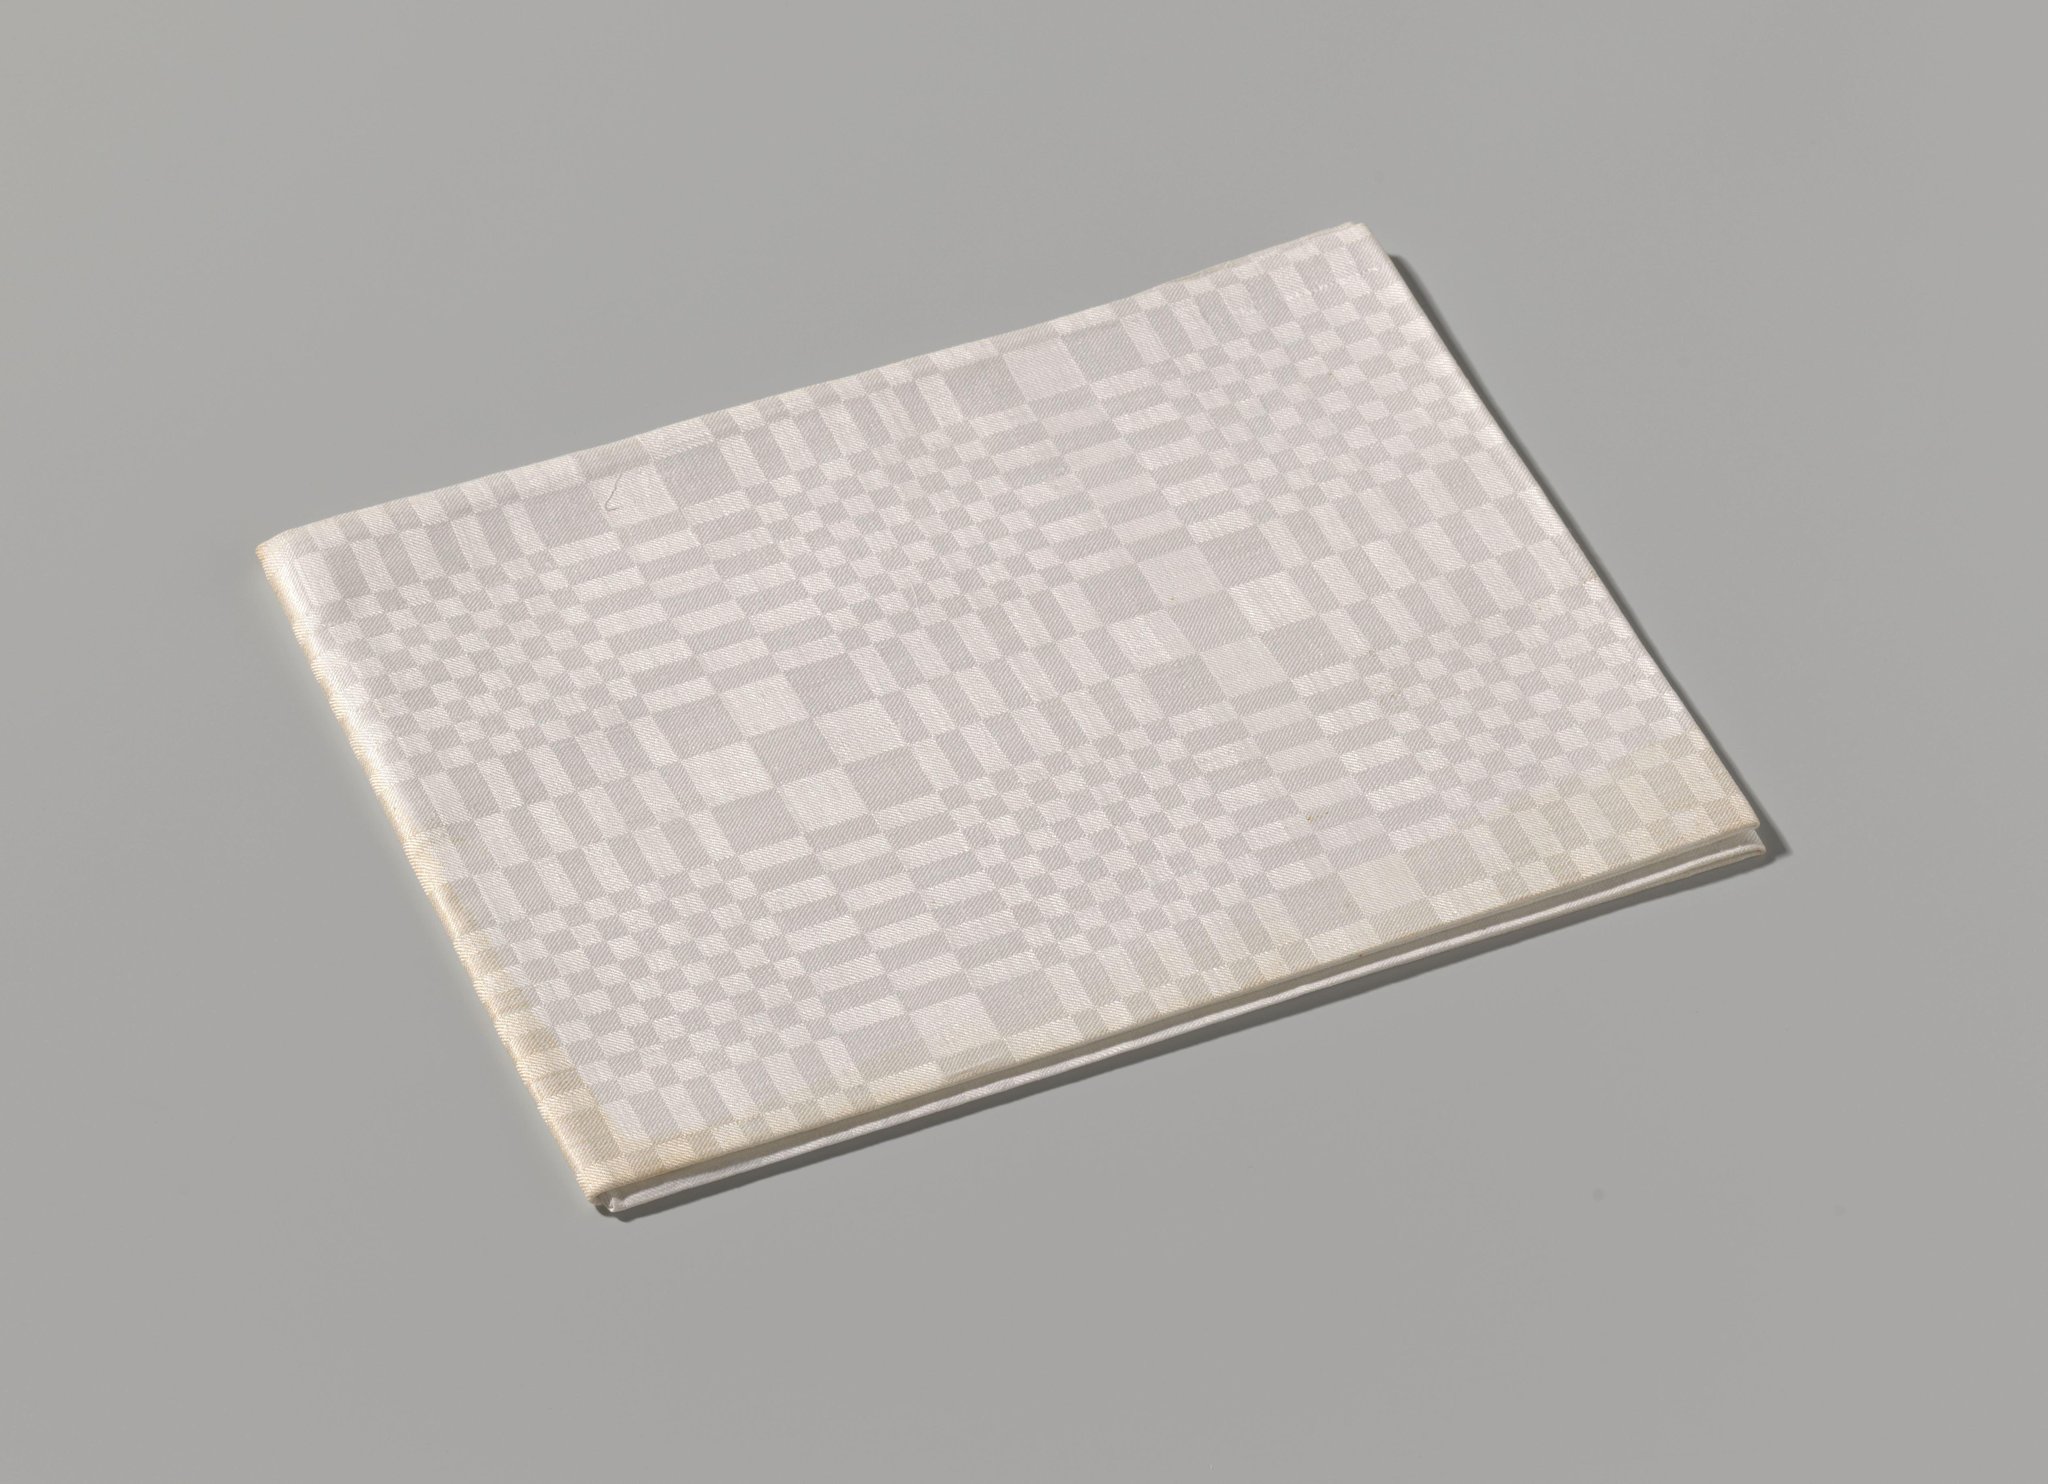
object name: napkin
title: Servet van pellendamast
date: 1739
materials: linen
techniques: weave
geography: northern netherlands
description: Wit linnen servet met pellenpatroon, genaamd "Engelse garderobe". Merk kroon WG 36 1739.